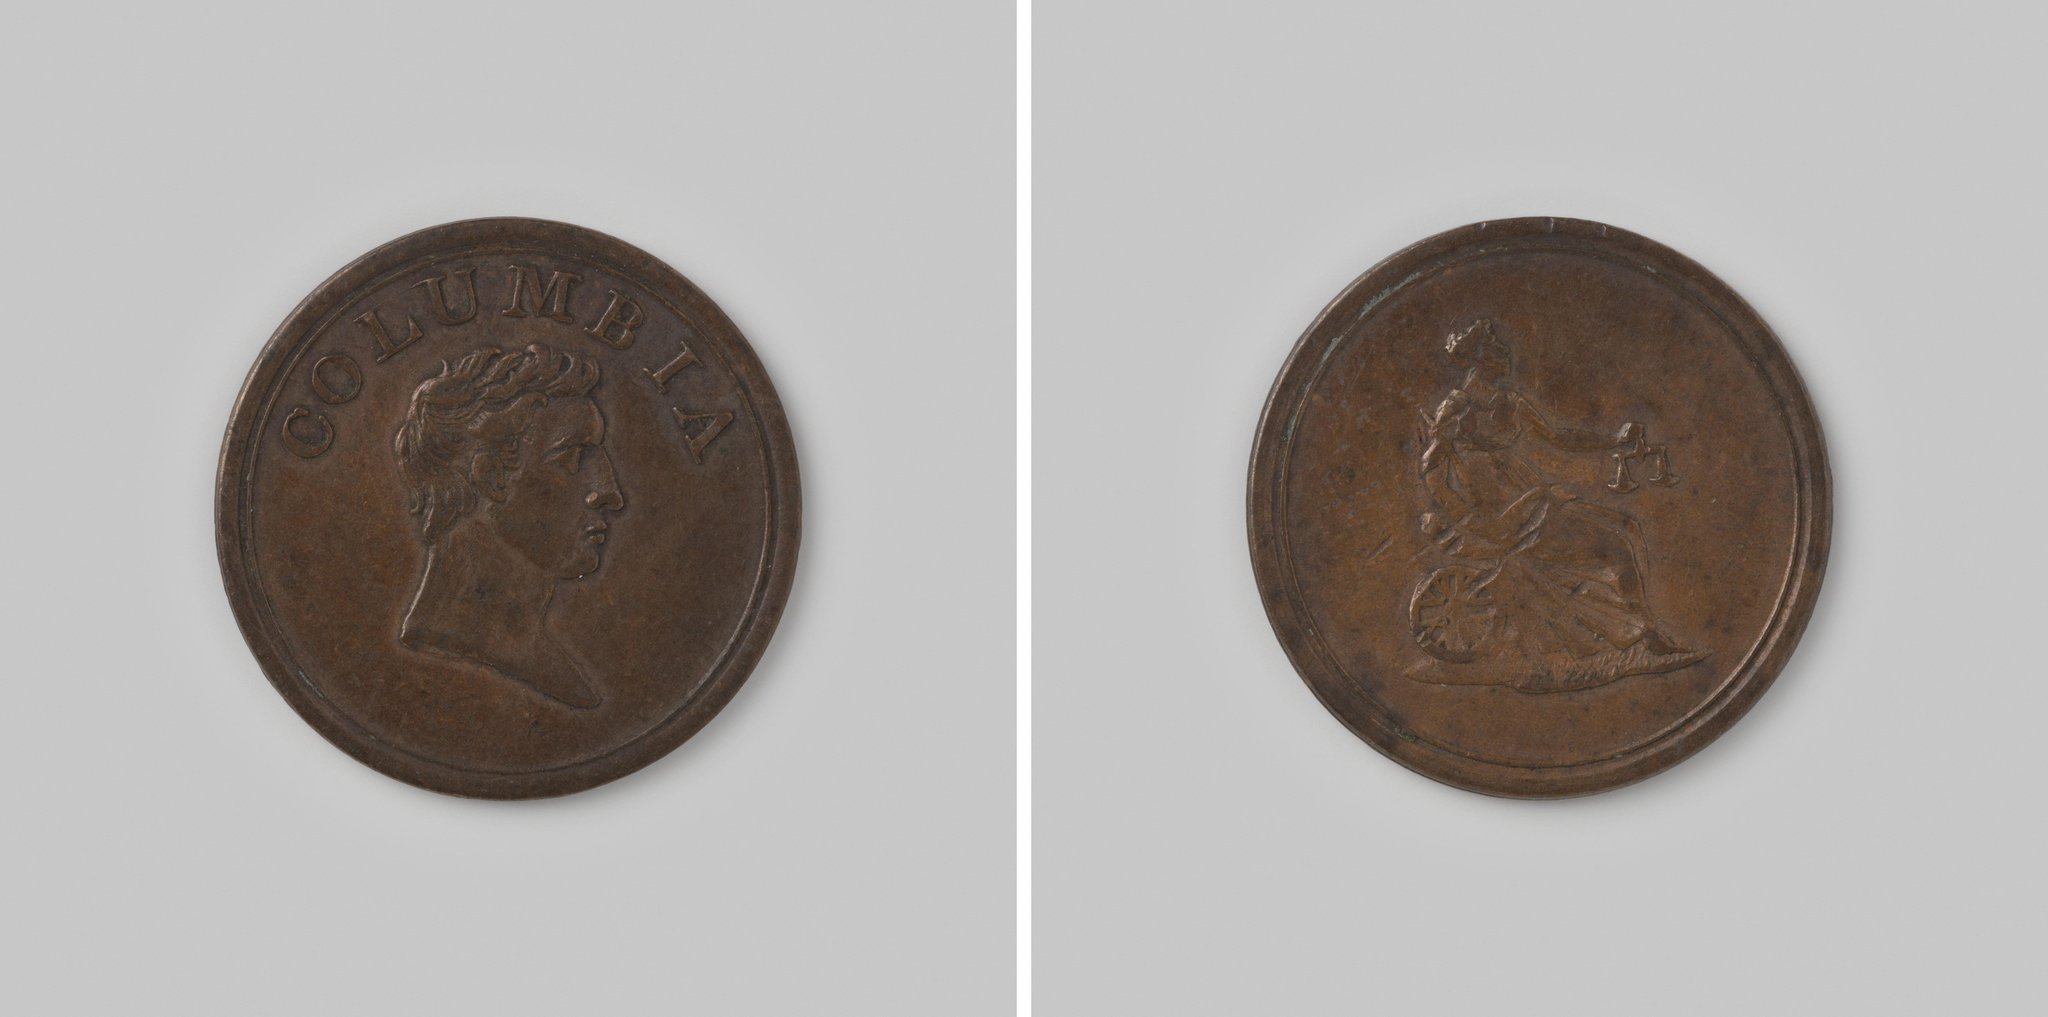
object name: coin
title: Colombia, cuartillo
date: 1830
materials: bronze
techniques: striking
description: Bronzen munt. Voorzijde: borstbeeld van Bolivar naar rechts. Keerzijde: vrouw naar rechts, gezeten op een wapenschild. Gladde rand. Geslagen in 1830 in Engeland.